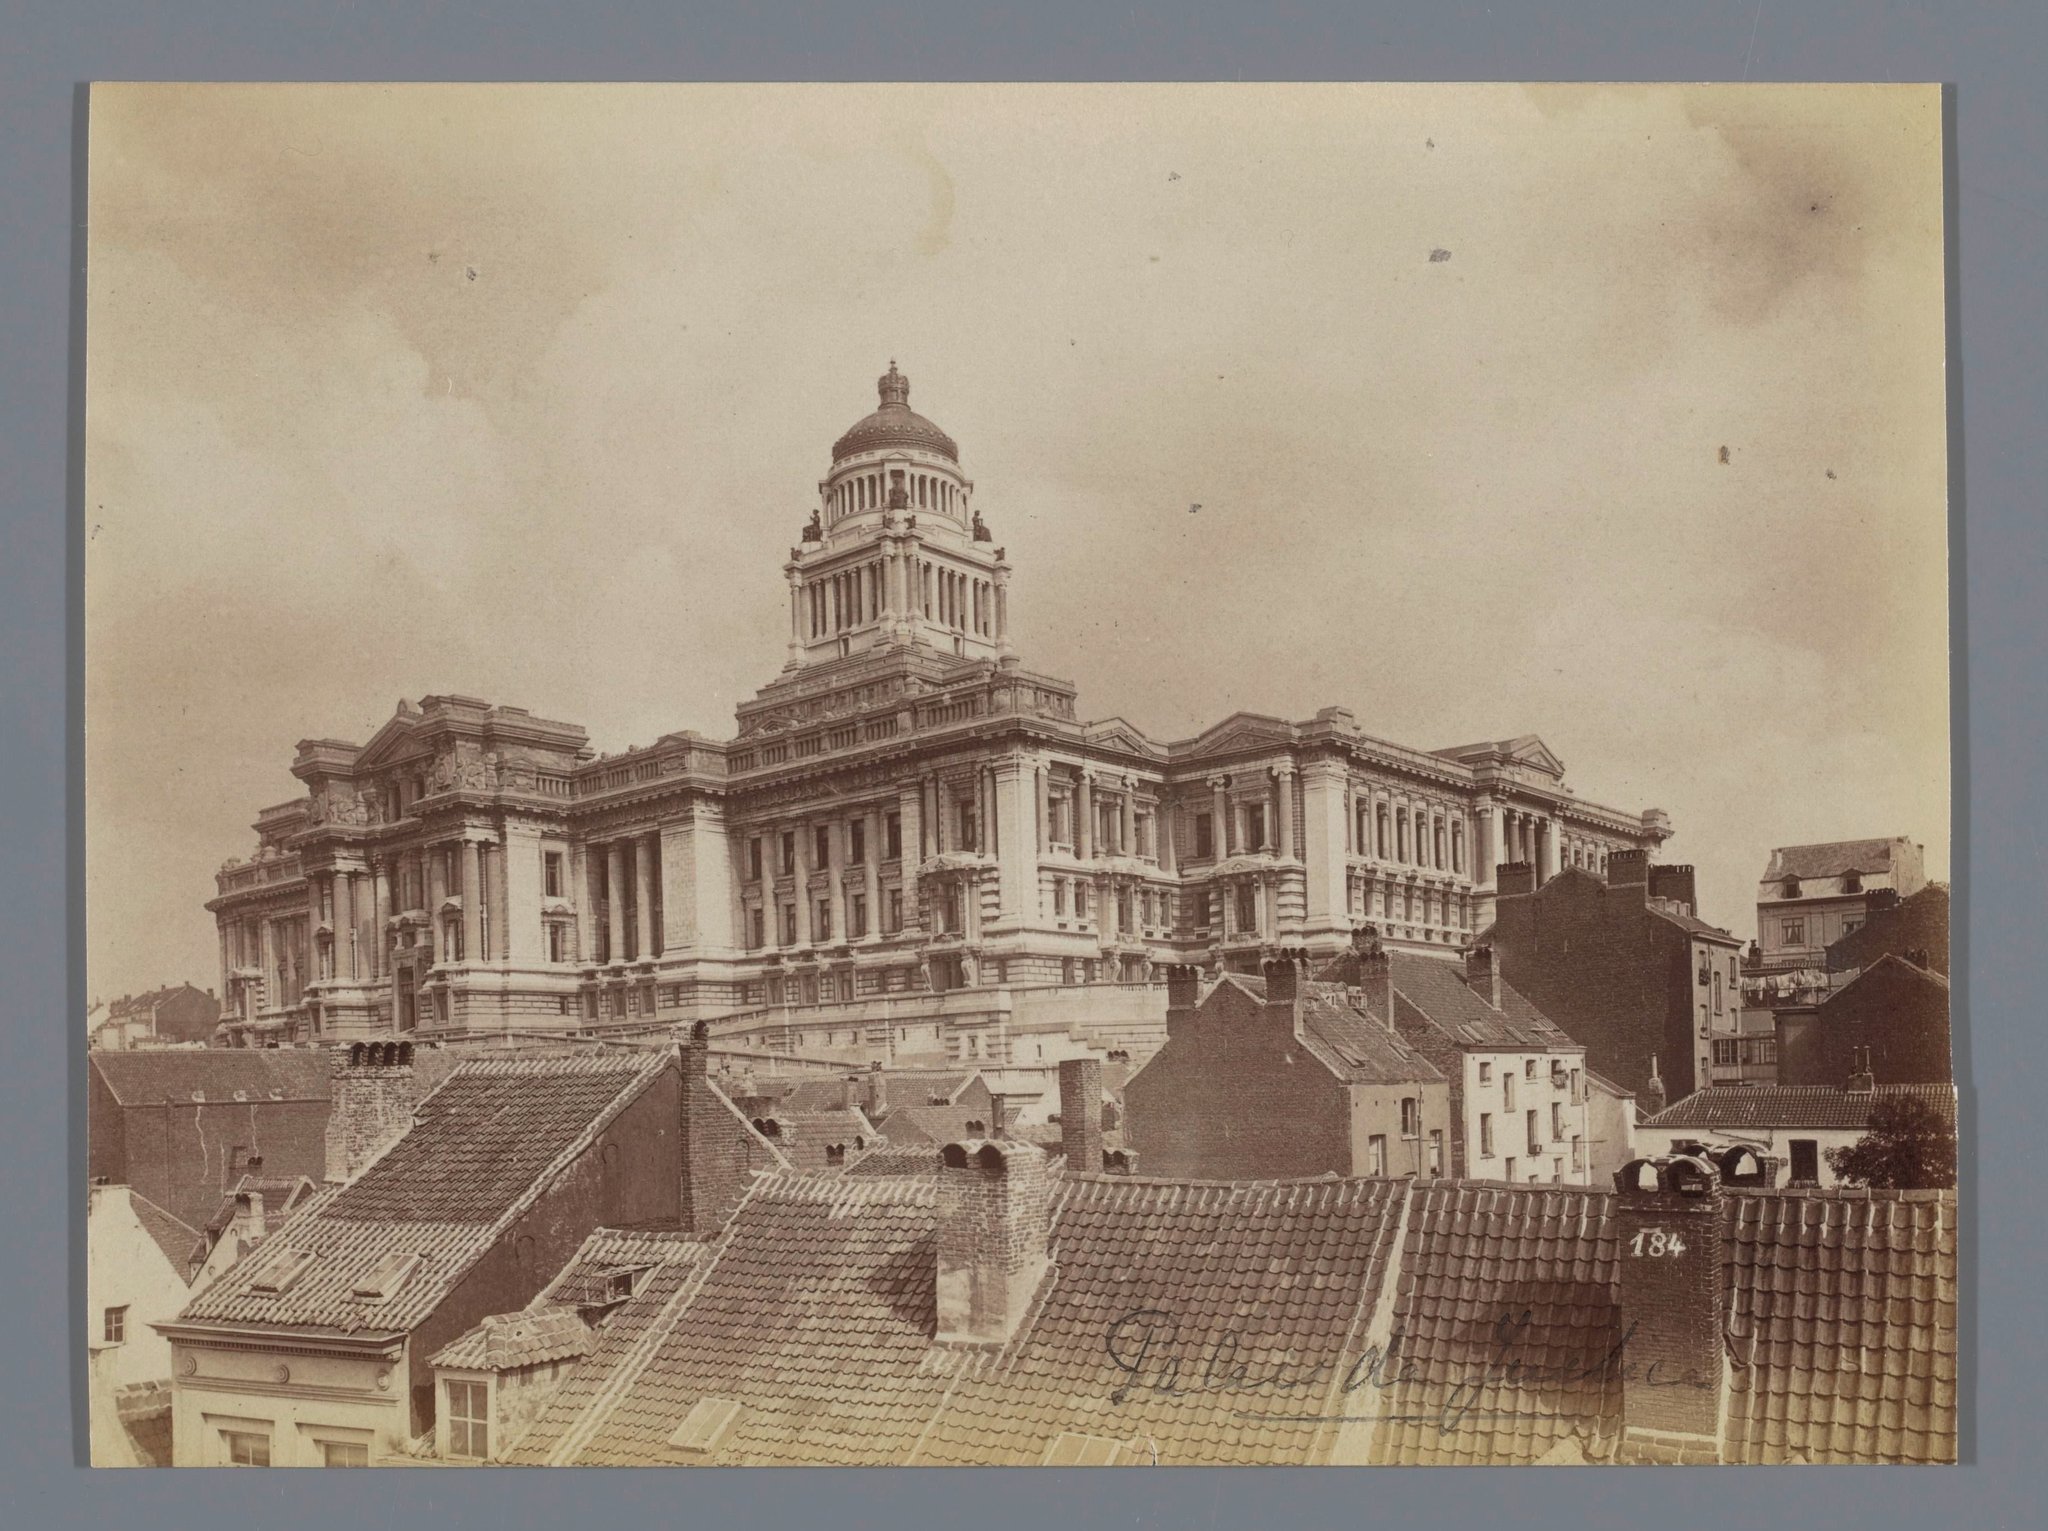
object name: photograph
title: Gezicht op het Paleis van Justitie te Brussel, België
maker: Anonymous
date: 1860-1900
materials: paper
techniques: albumen print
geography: brussels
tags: exterior ~ representation of a building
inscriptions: number: ‘184.’